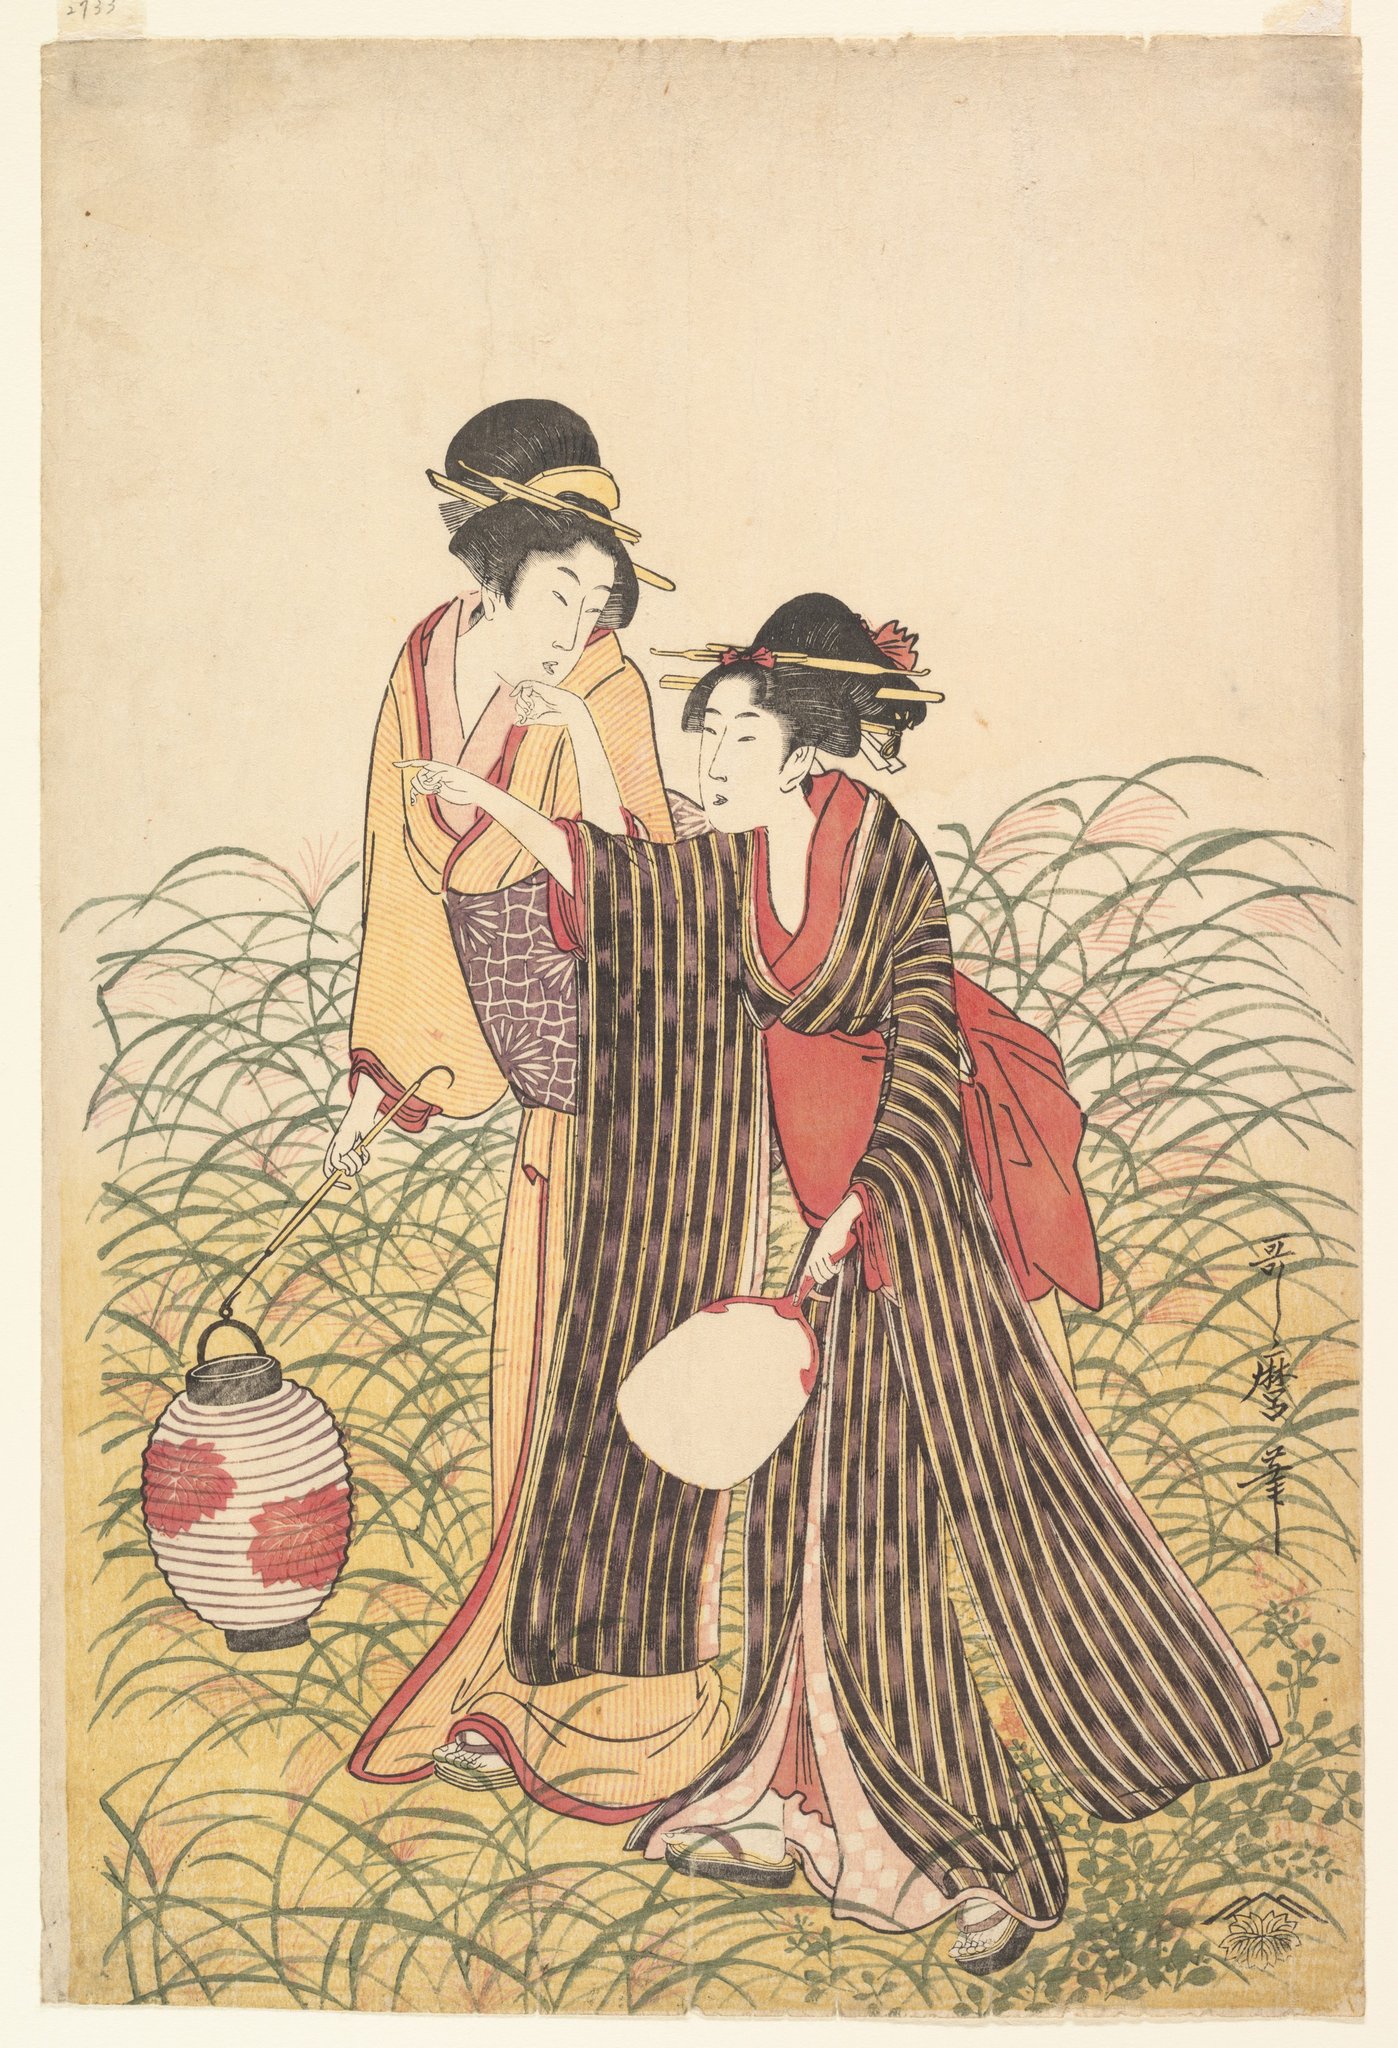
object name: print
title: Elopers in Musashino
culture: japanese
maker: kitagawa utamaro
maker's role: artist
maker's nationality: japanese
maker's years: 1754-1806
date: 1801-1833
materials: ink, paper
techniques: woodblock print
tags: women,leaves